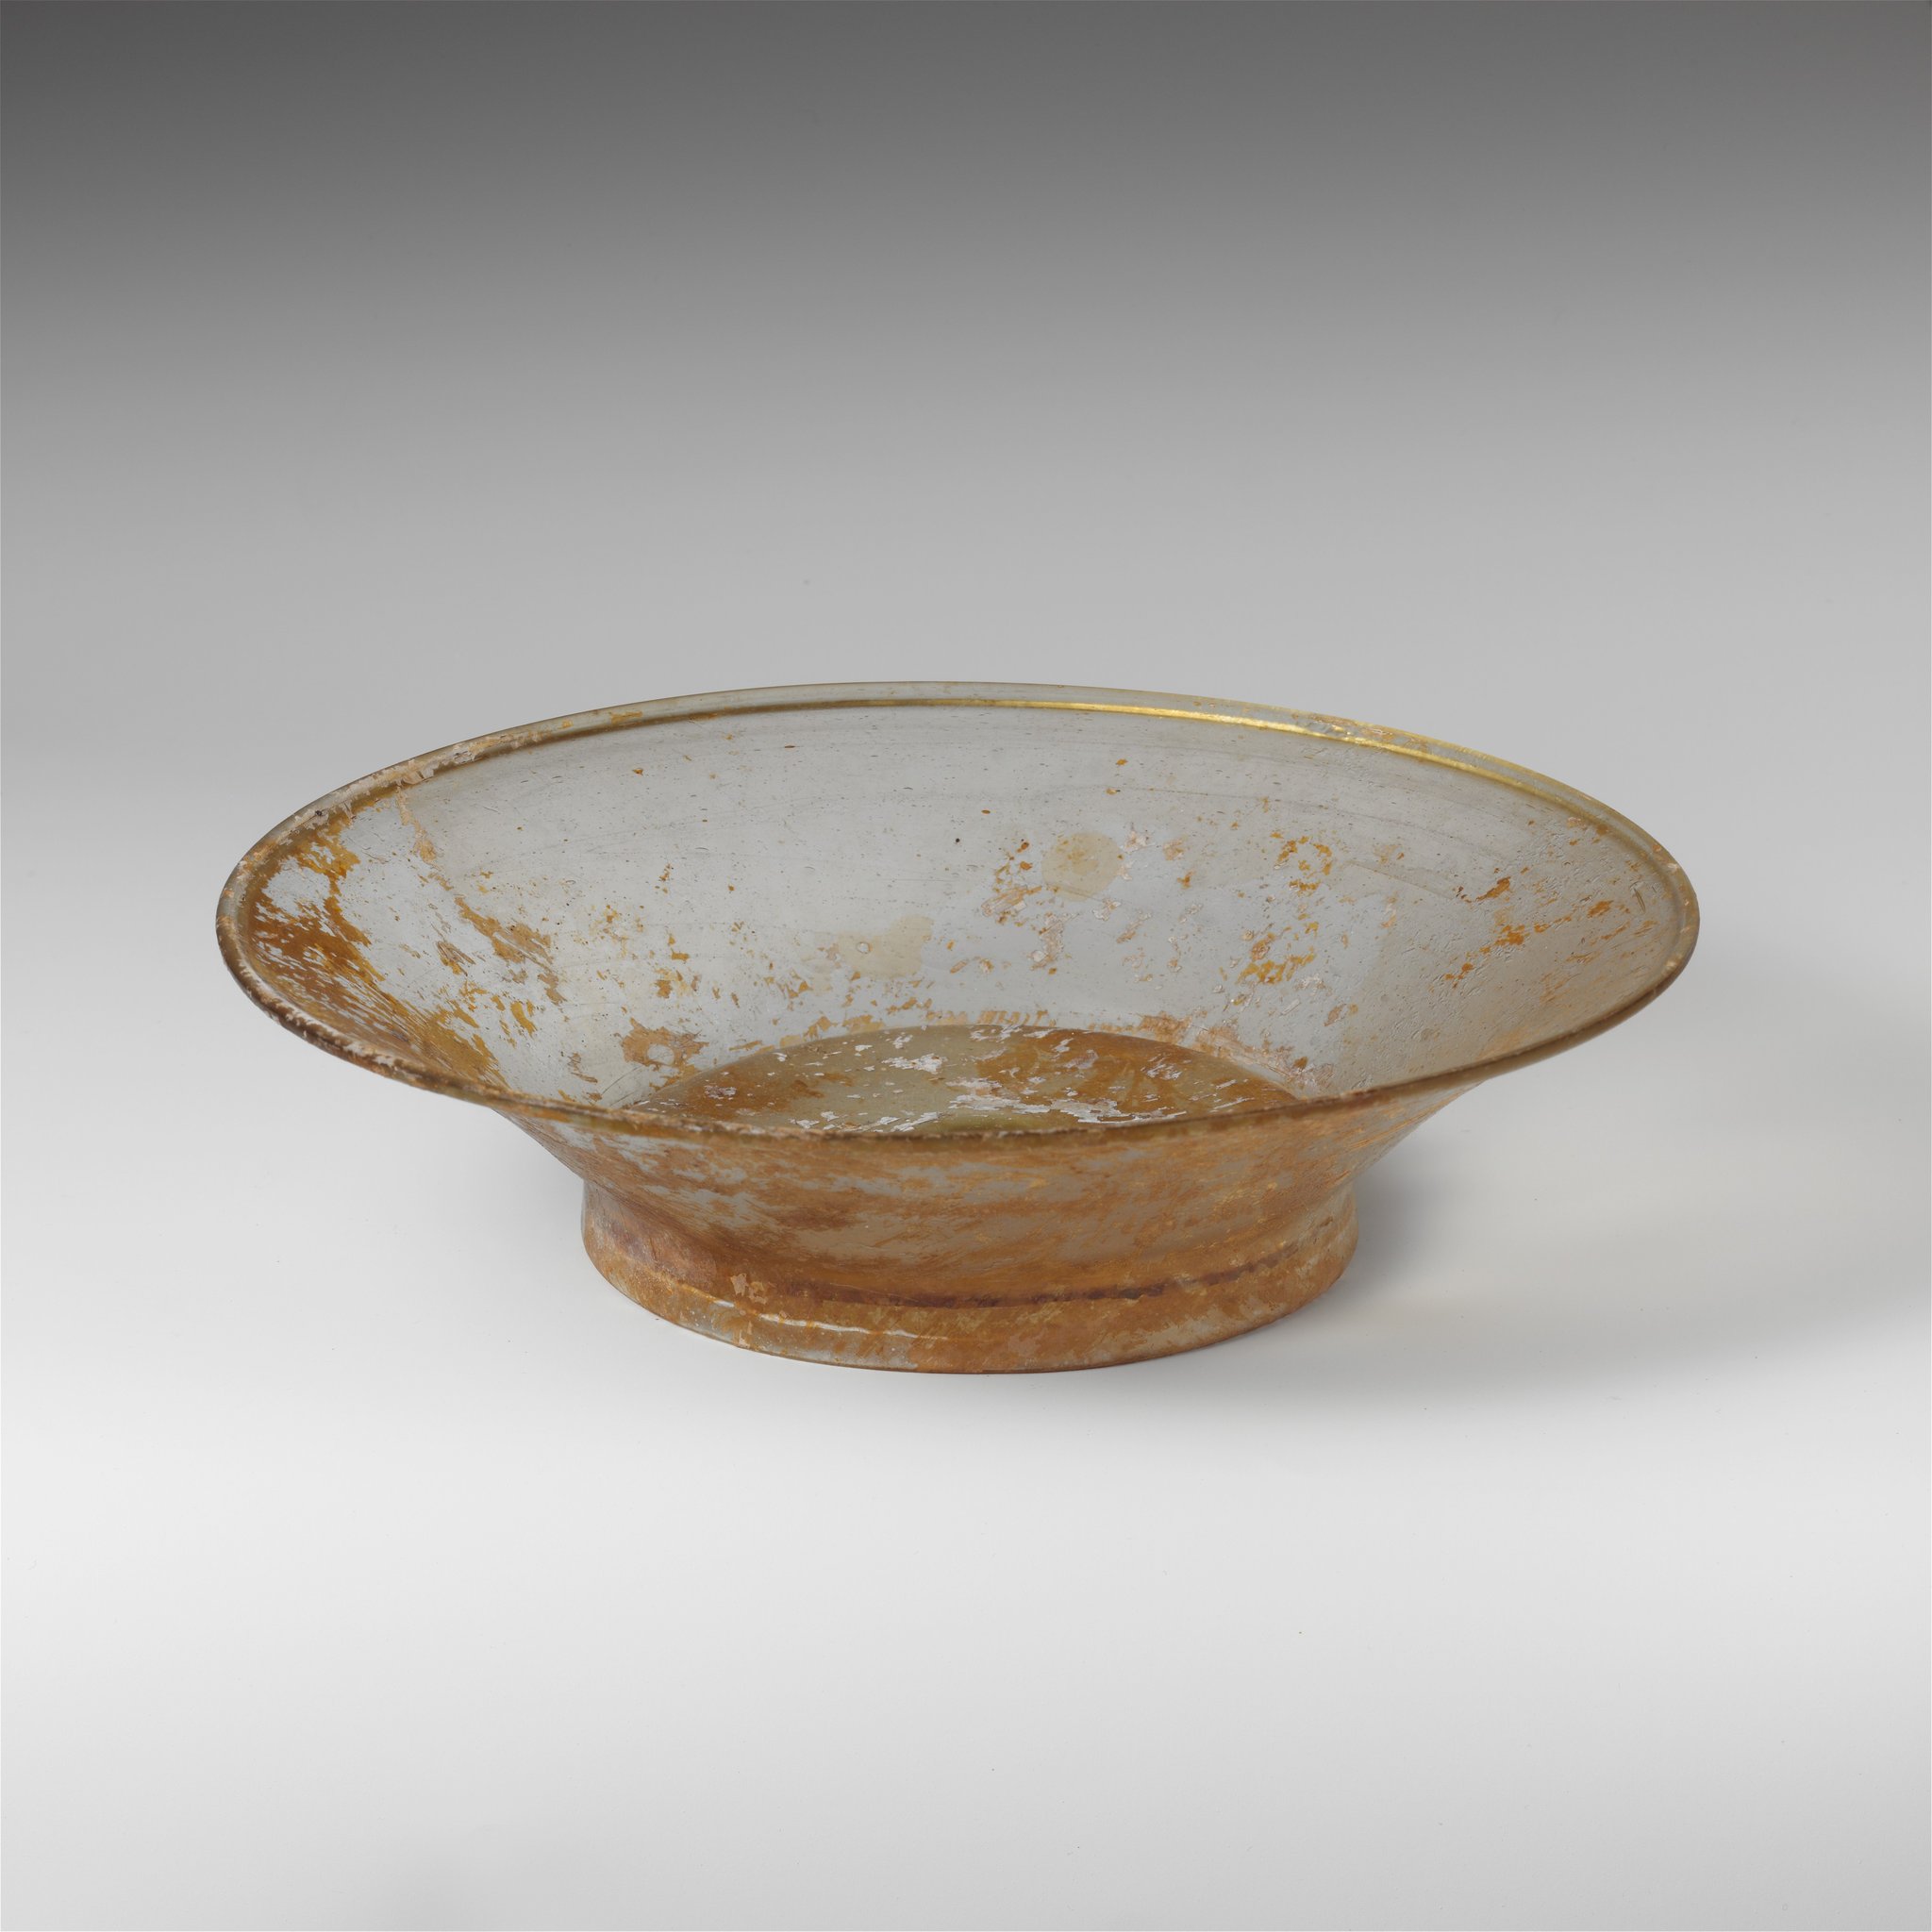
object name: dish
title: Glass dish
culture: roman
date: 301-400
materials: glass